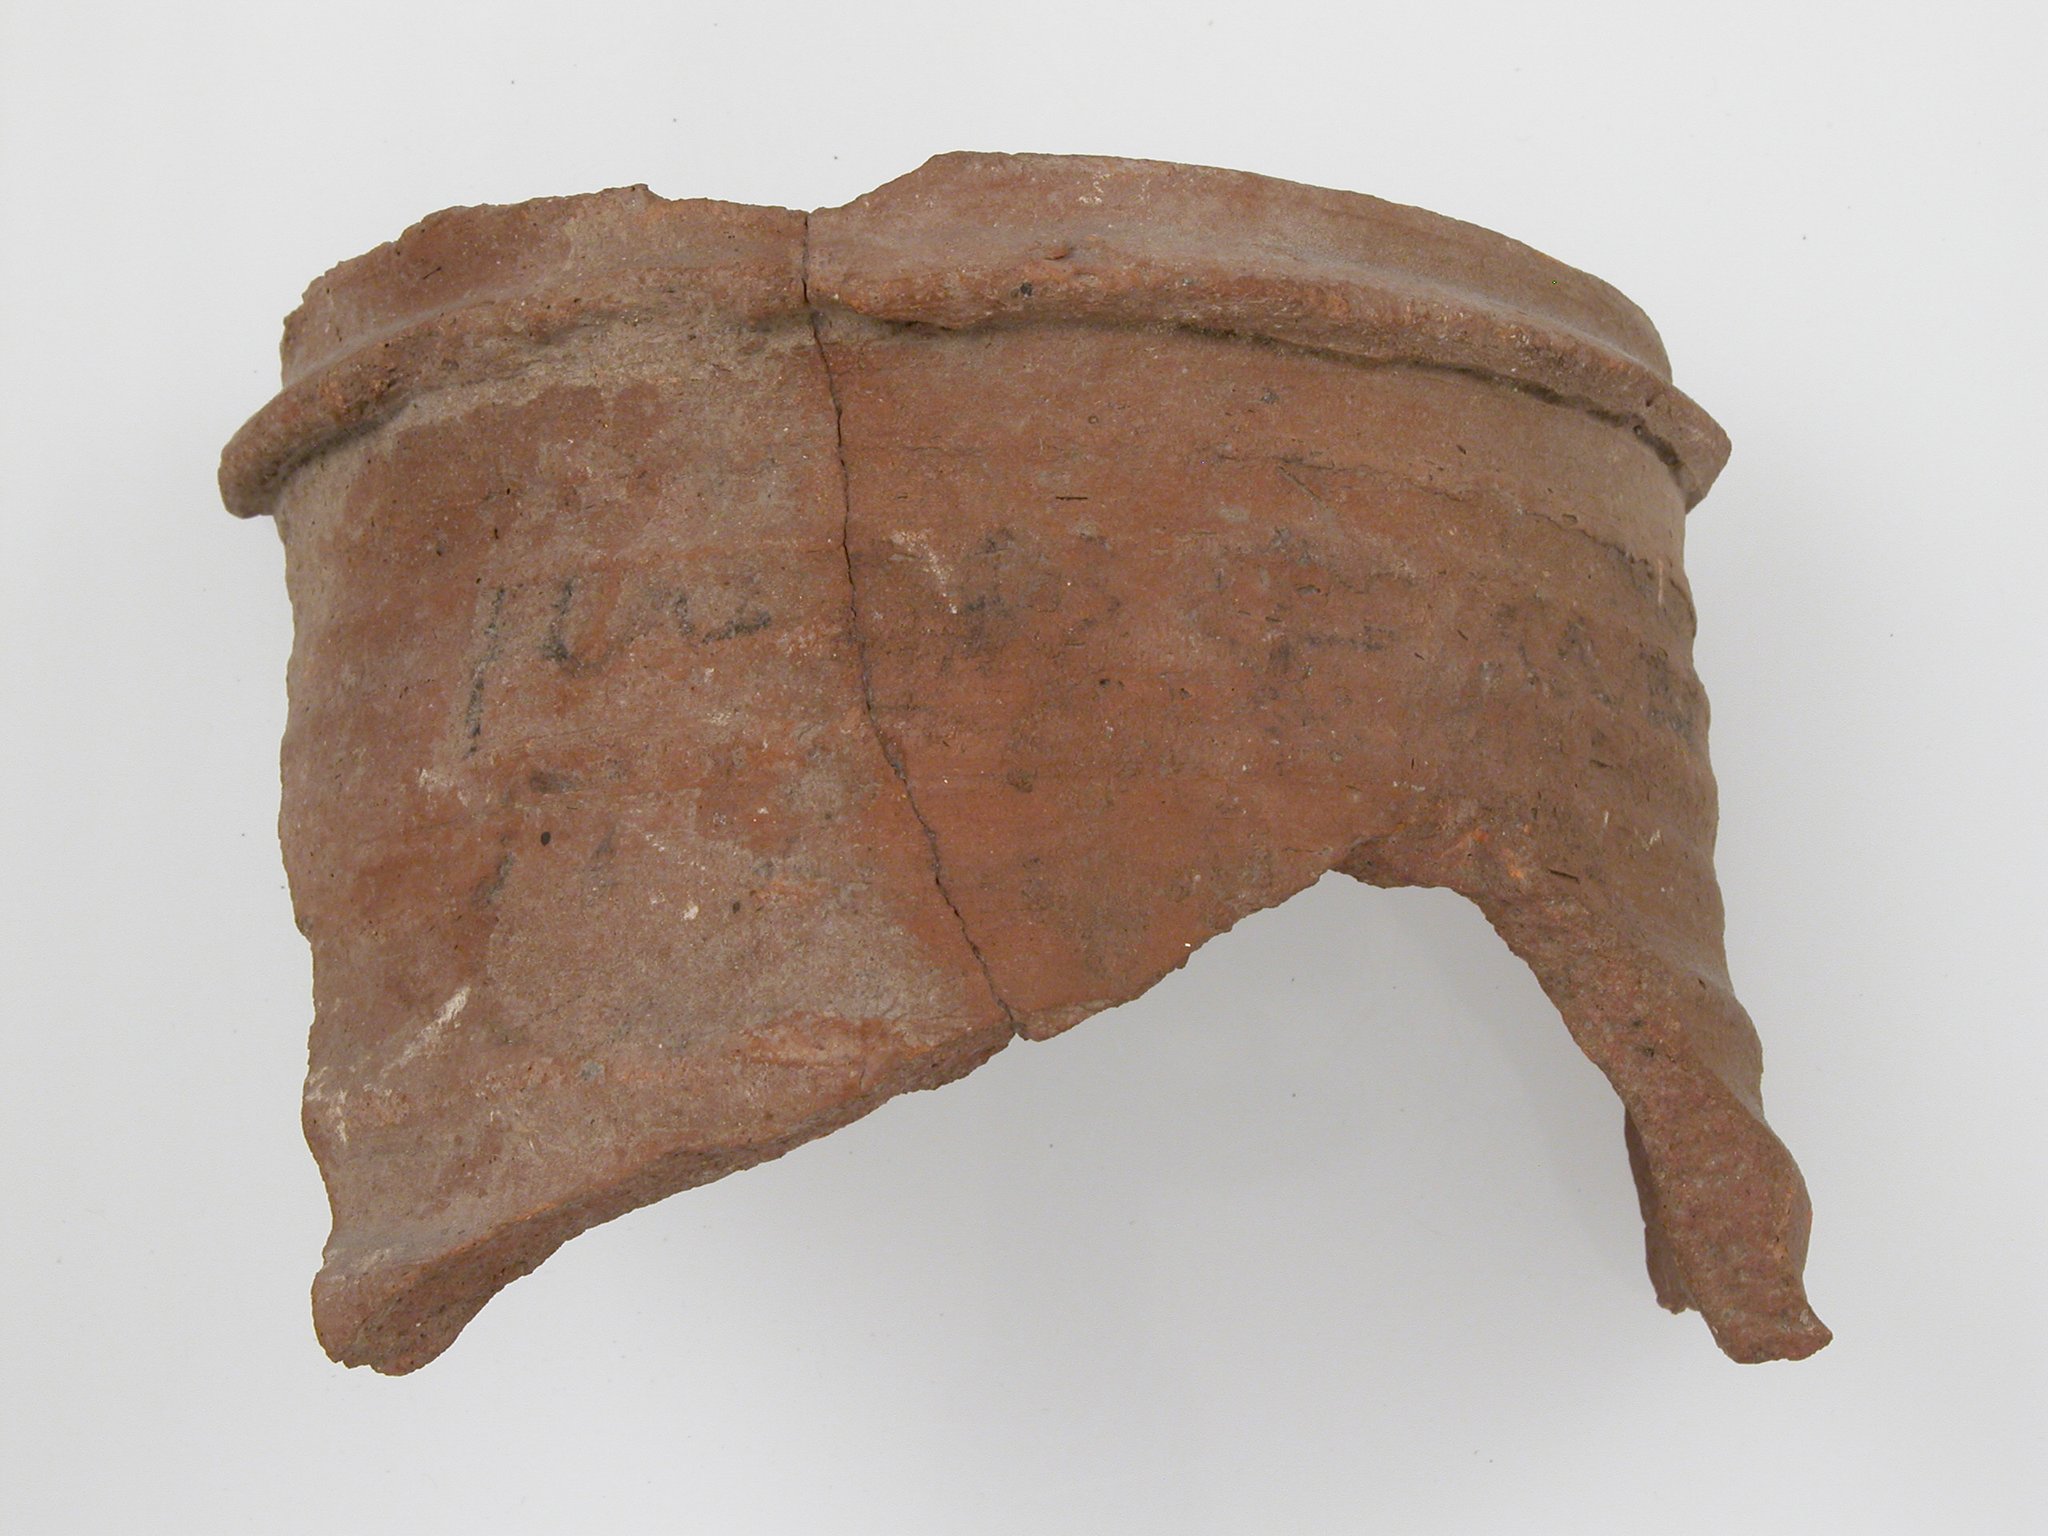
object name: ostrakon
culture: coptic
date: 600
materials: ink, pottery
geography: egypt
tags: coptic,documents